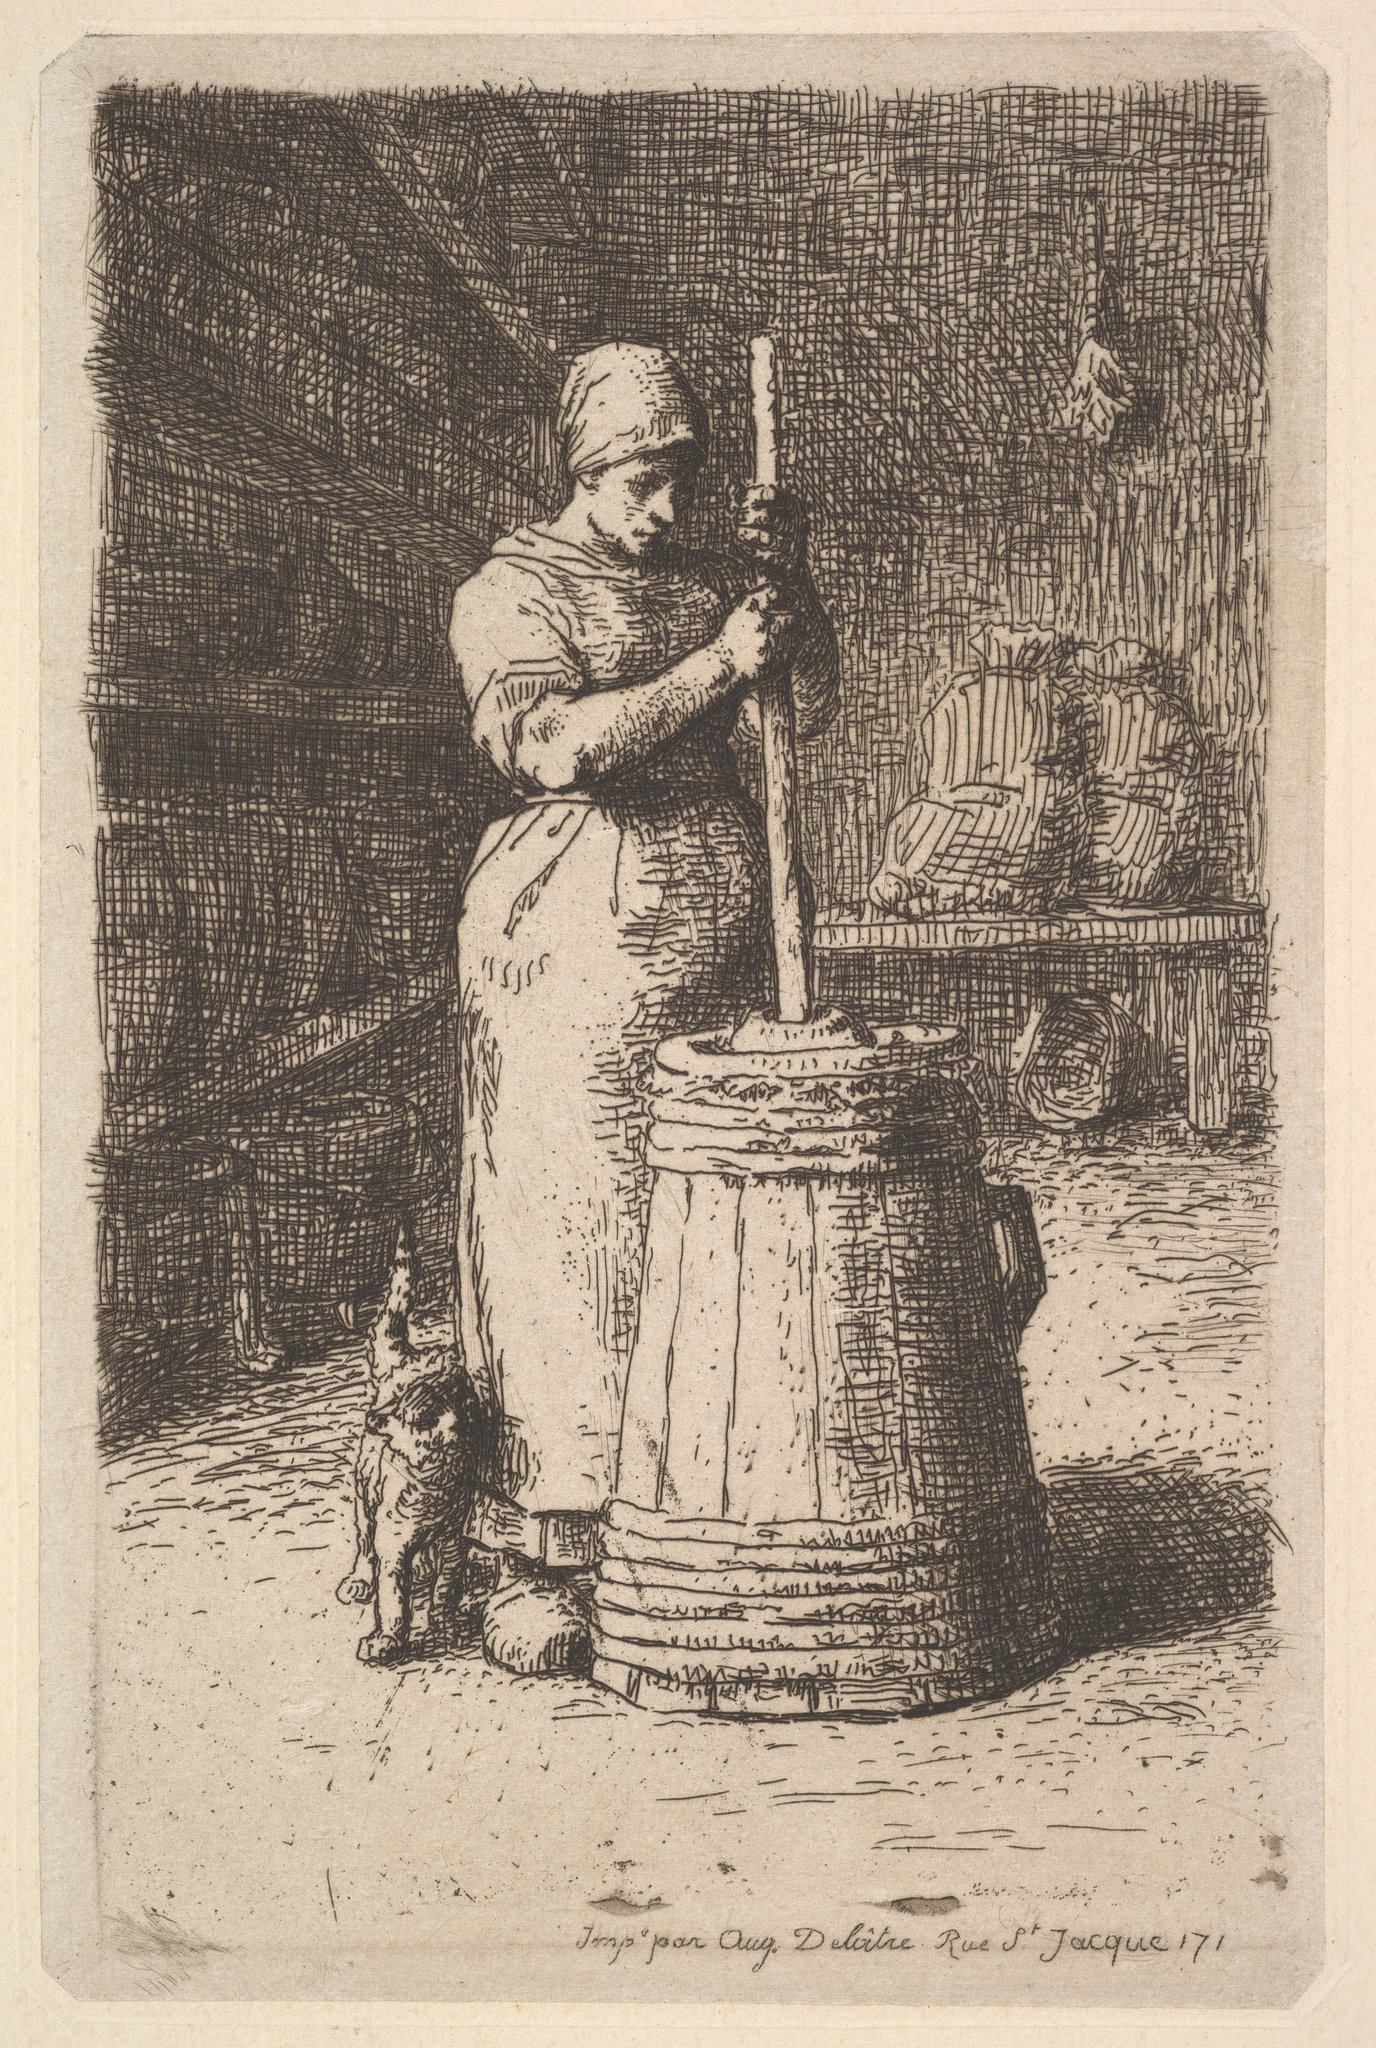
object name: print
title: Woman Churning Butter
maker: jean-françois millet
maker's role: artist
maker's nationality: french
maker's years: 1814-1875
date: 1855-1856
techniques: etching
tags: women,cats